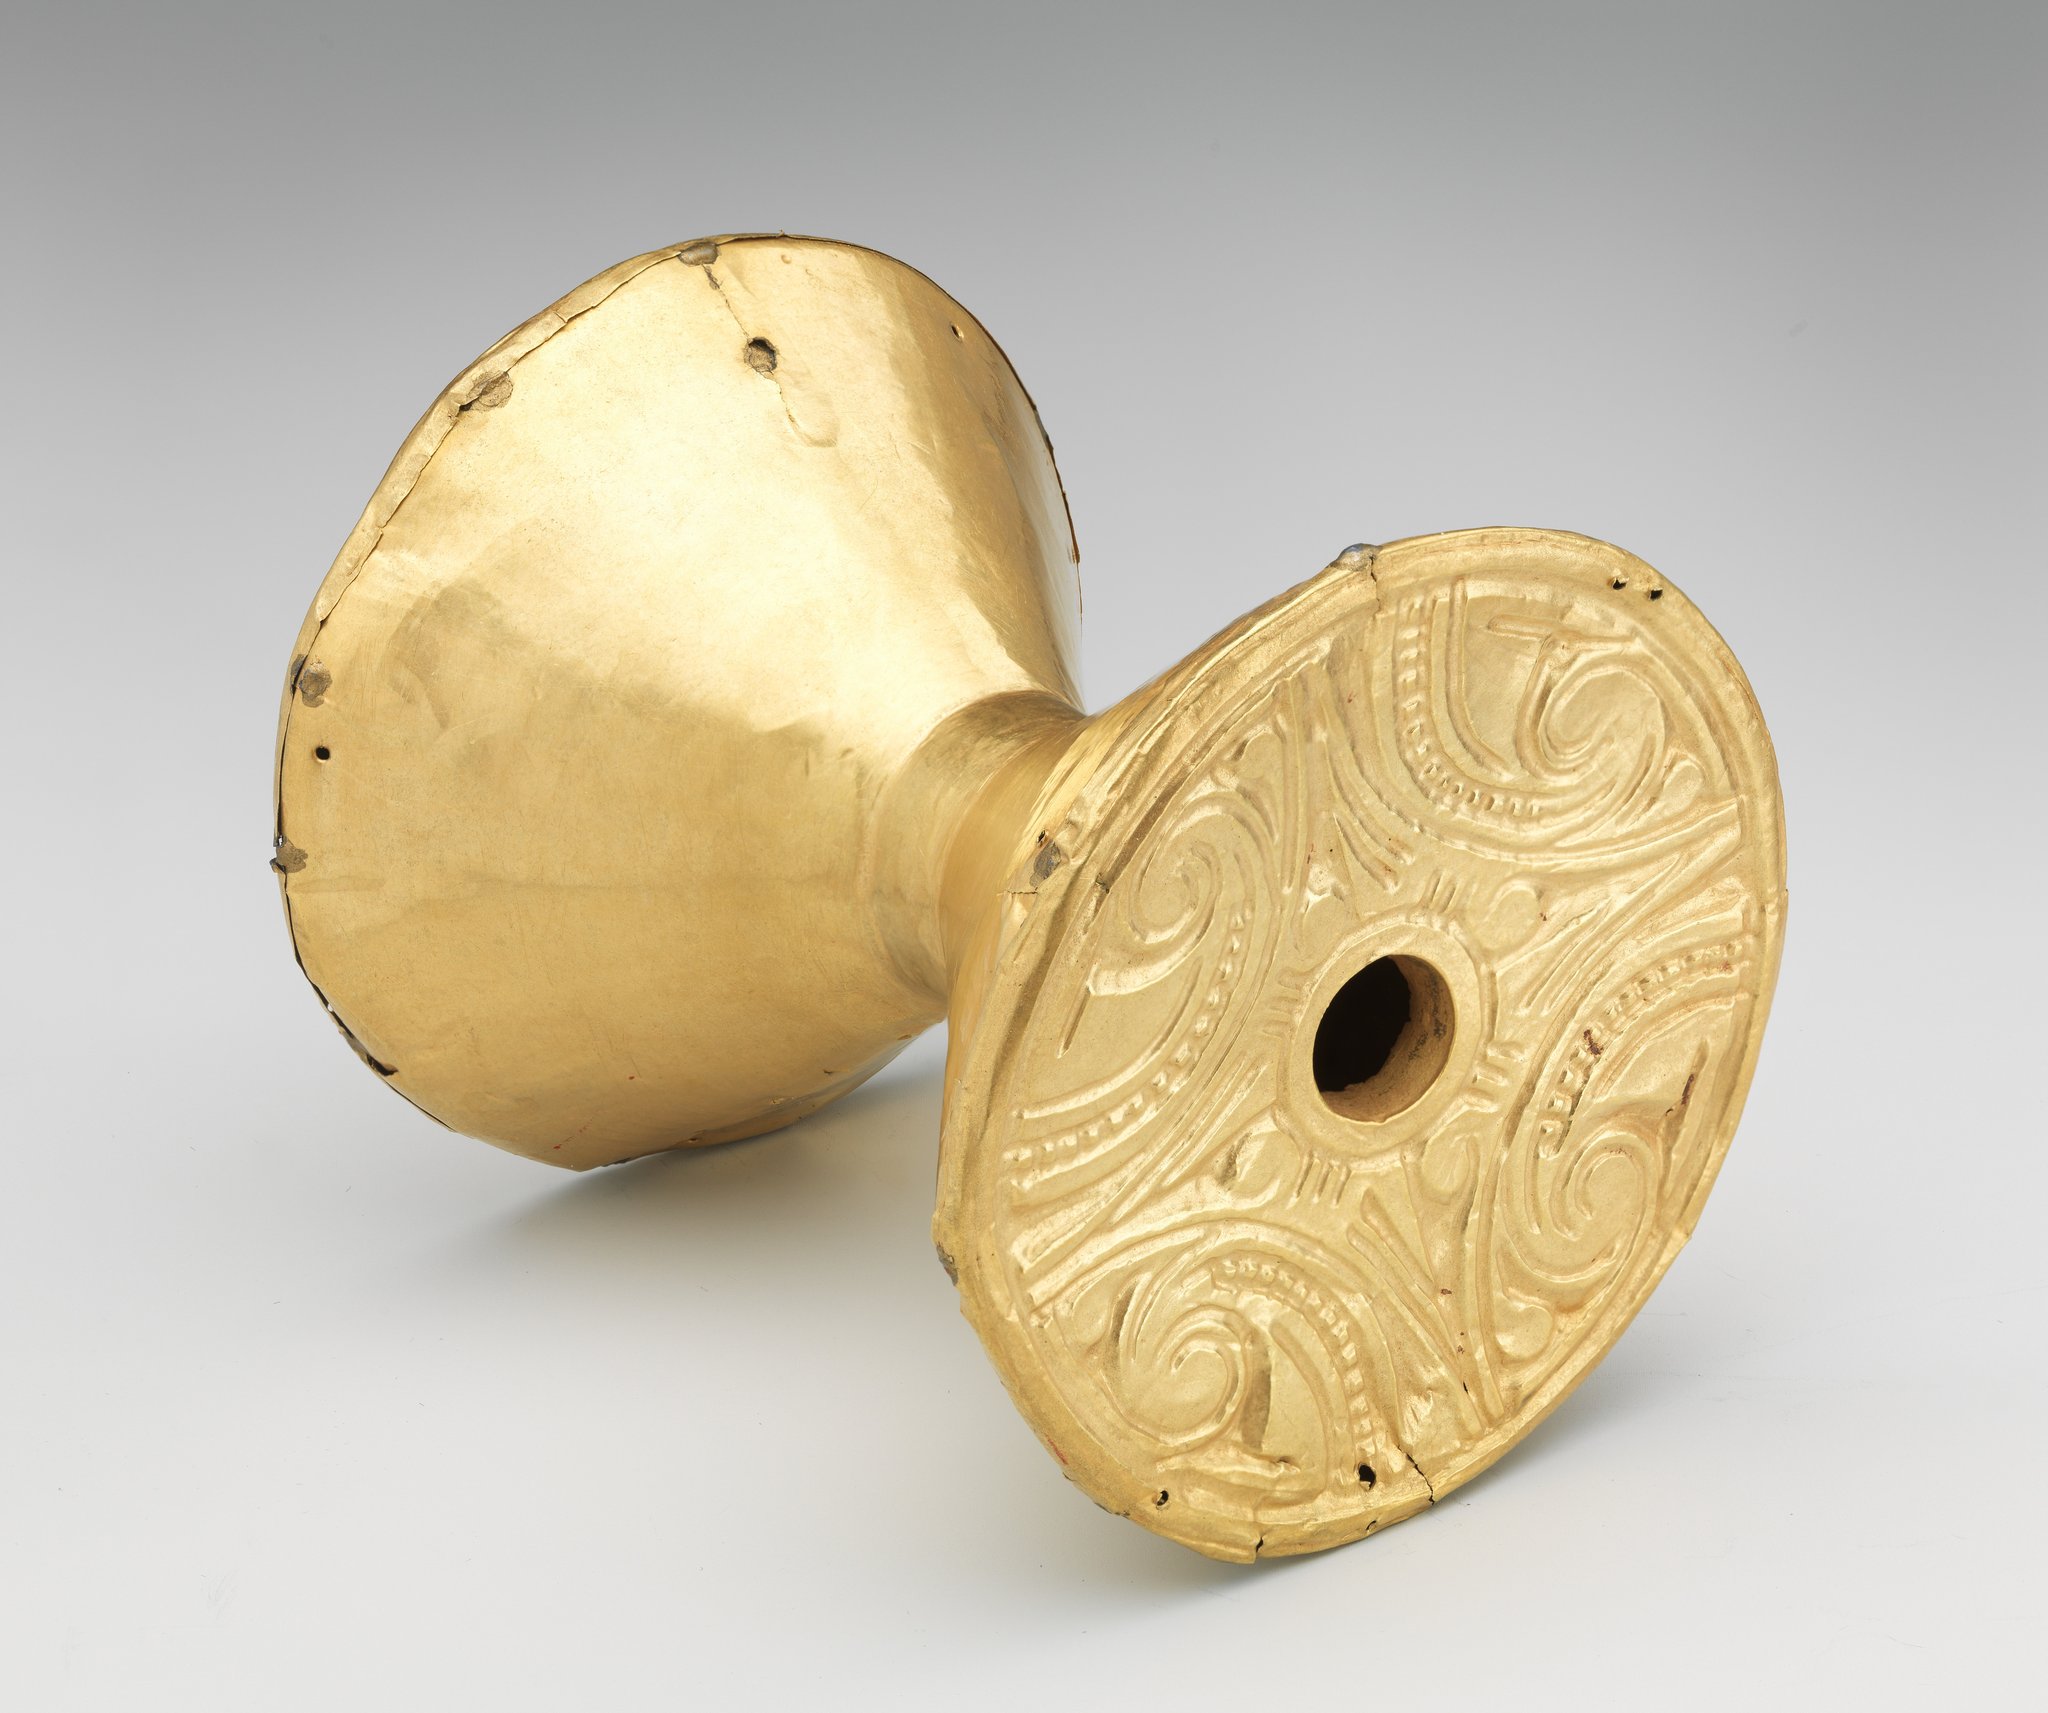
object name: ear spool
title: Earspool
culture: calima-yotoco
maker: calima (yotoco) artist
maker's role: artist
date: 100 BCE-700 CE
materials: gold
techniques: hammering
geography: colombia